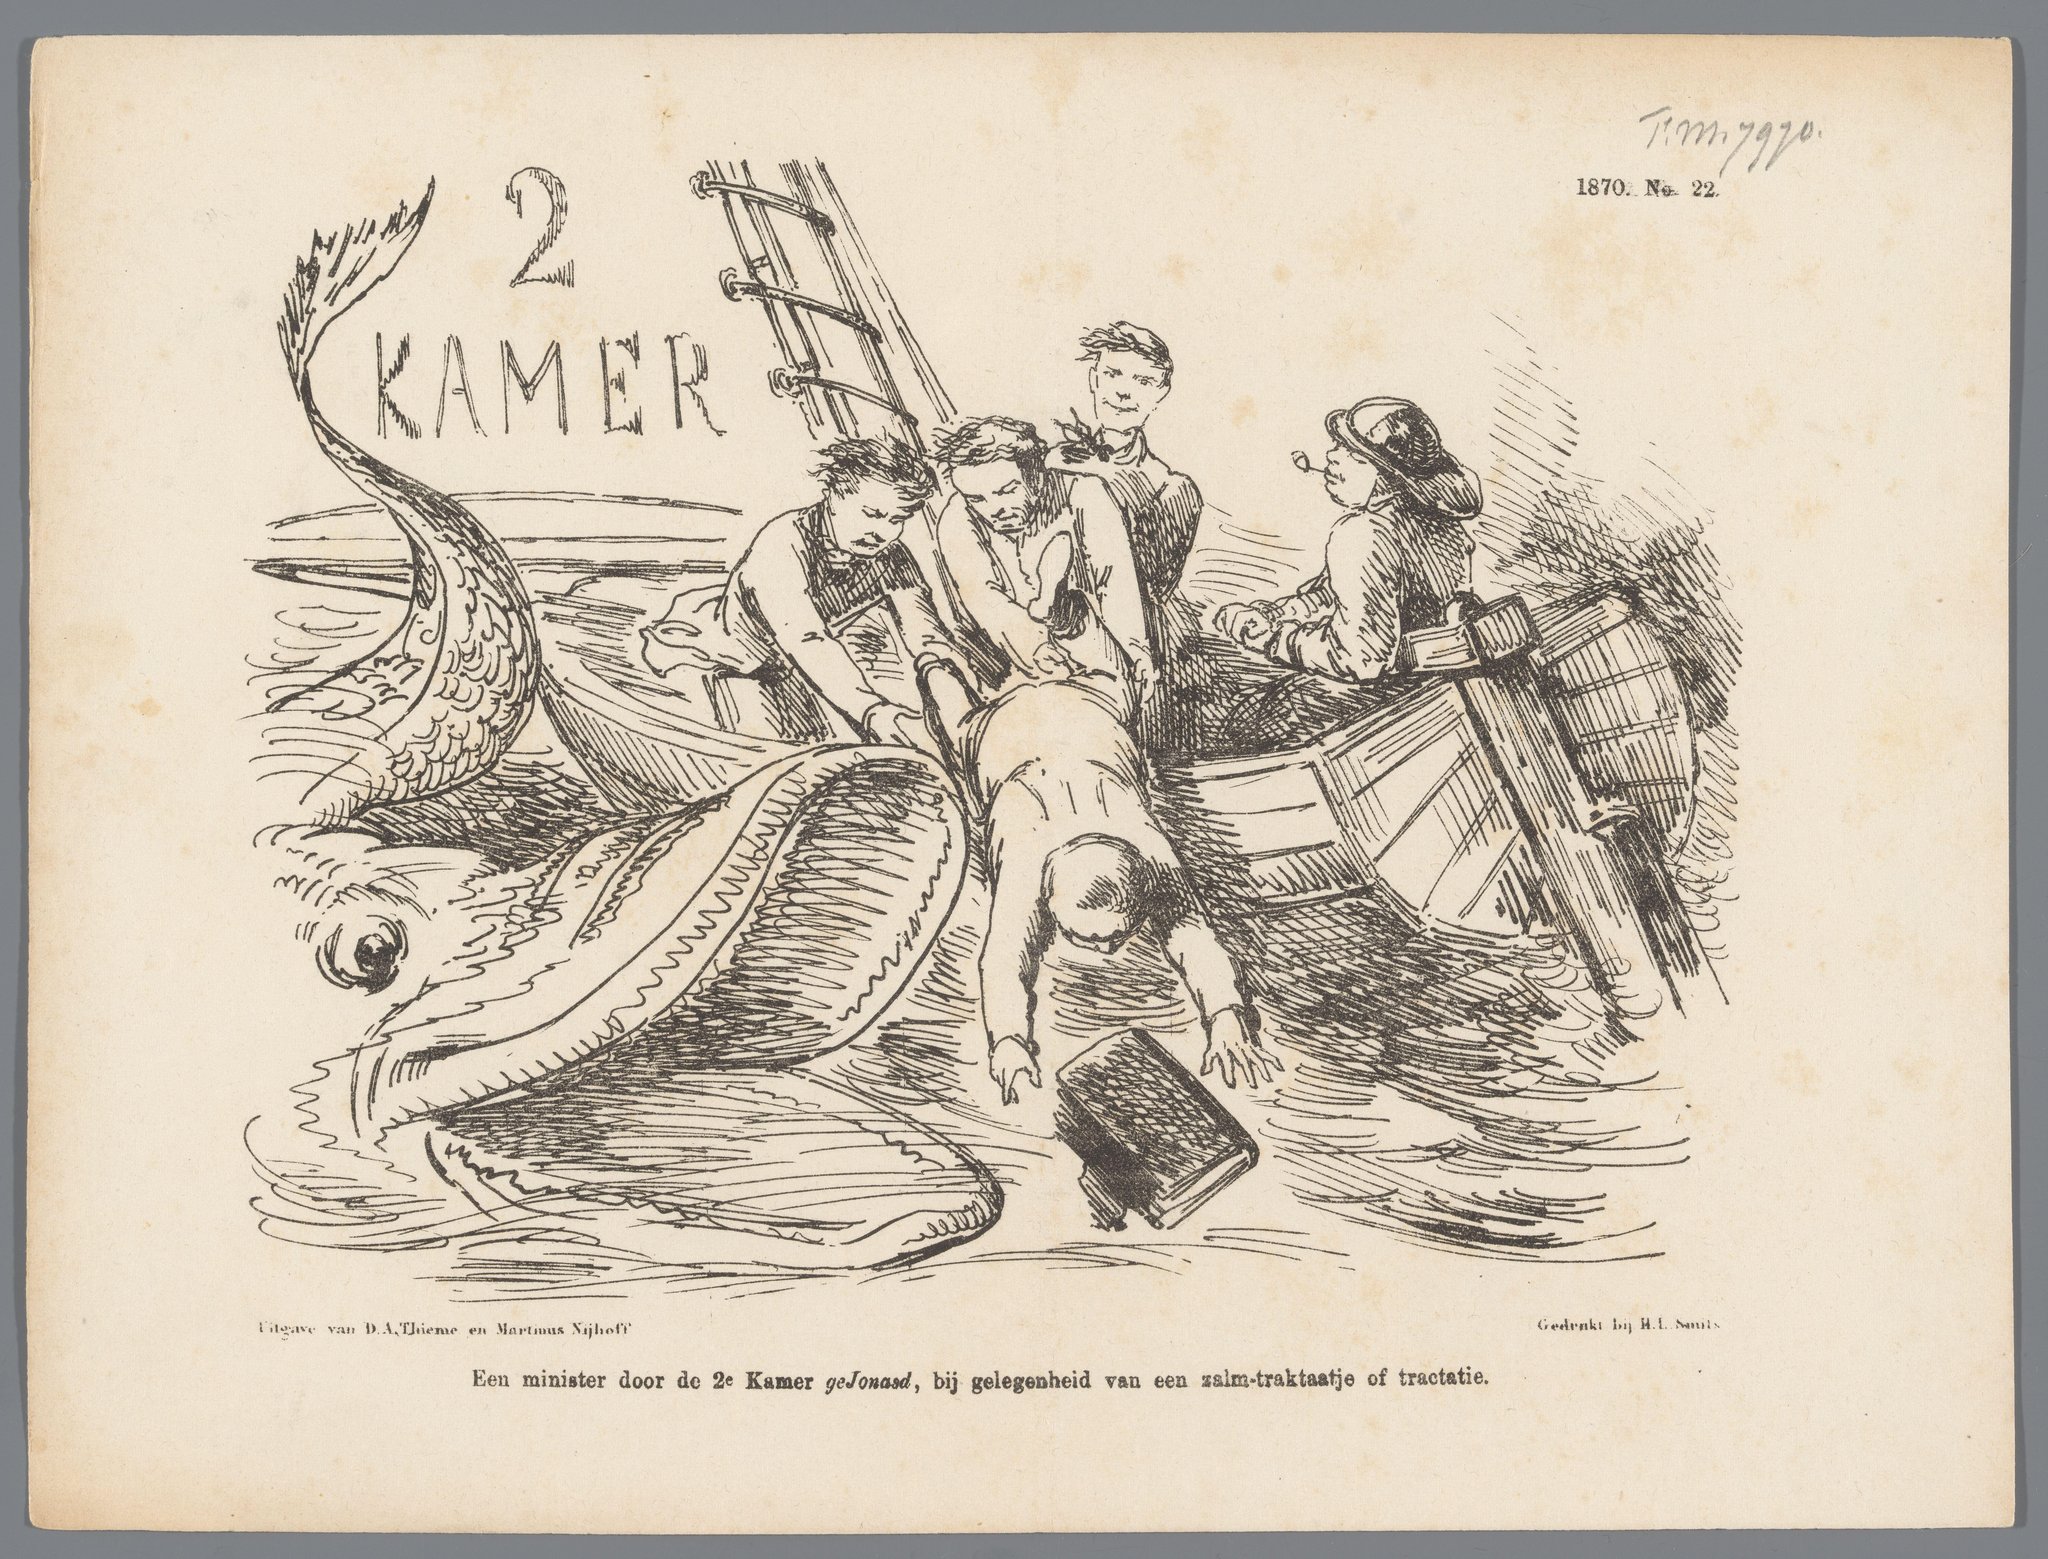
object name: cartoon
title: Een minister door de 2e Kamer geJonasd, bij gelegenheid van een zalm-traktaatje of tractatie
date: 1870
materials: paper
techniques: lithograph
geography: the hague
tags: the sailors reluctantly throw the prophet jonah into the sea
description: Spotprent op Minister van Buitenlandse Zaken Roest van Limburg die als Jonas overboord wordt gezet. Naar aanleiding van het verwerpen van een tractaat over visserij in de Rijn. Plaat verschenen bij het weekblad De Nederlandsche Spectator, nr. 22, 1870.